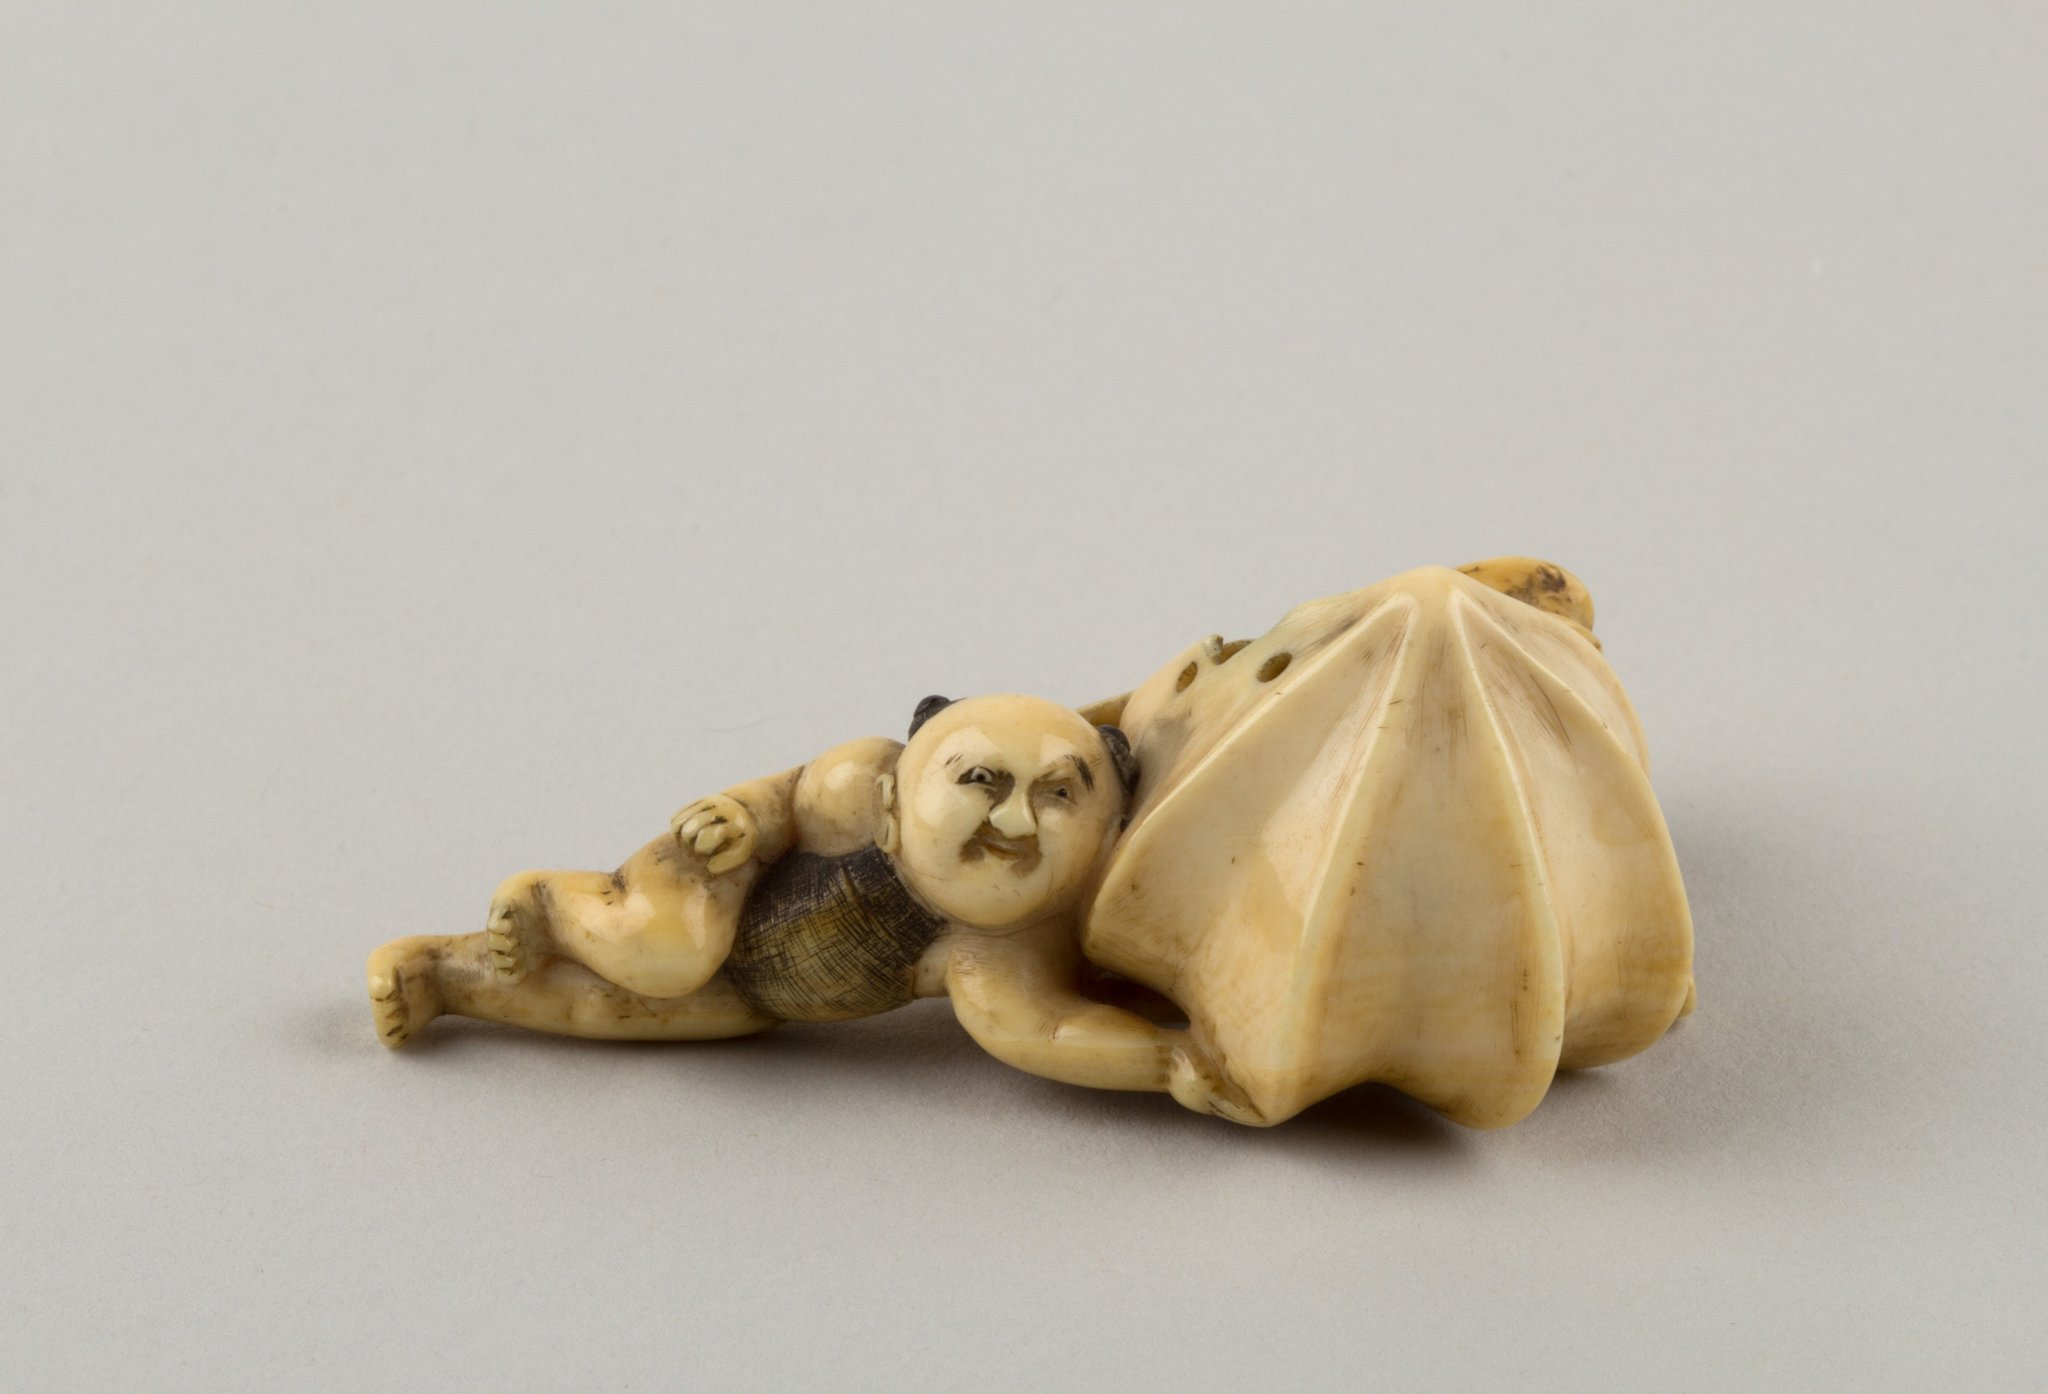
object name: netsuke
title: Netsuke of Boy Carrying a Branch of Fruit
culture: japanese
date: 1801-1900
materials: ivory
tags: fruit